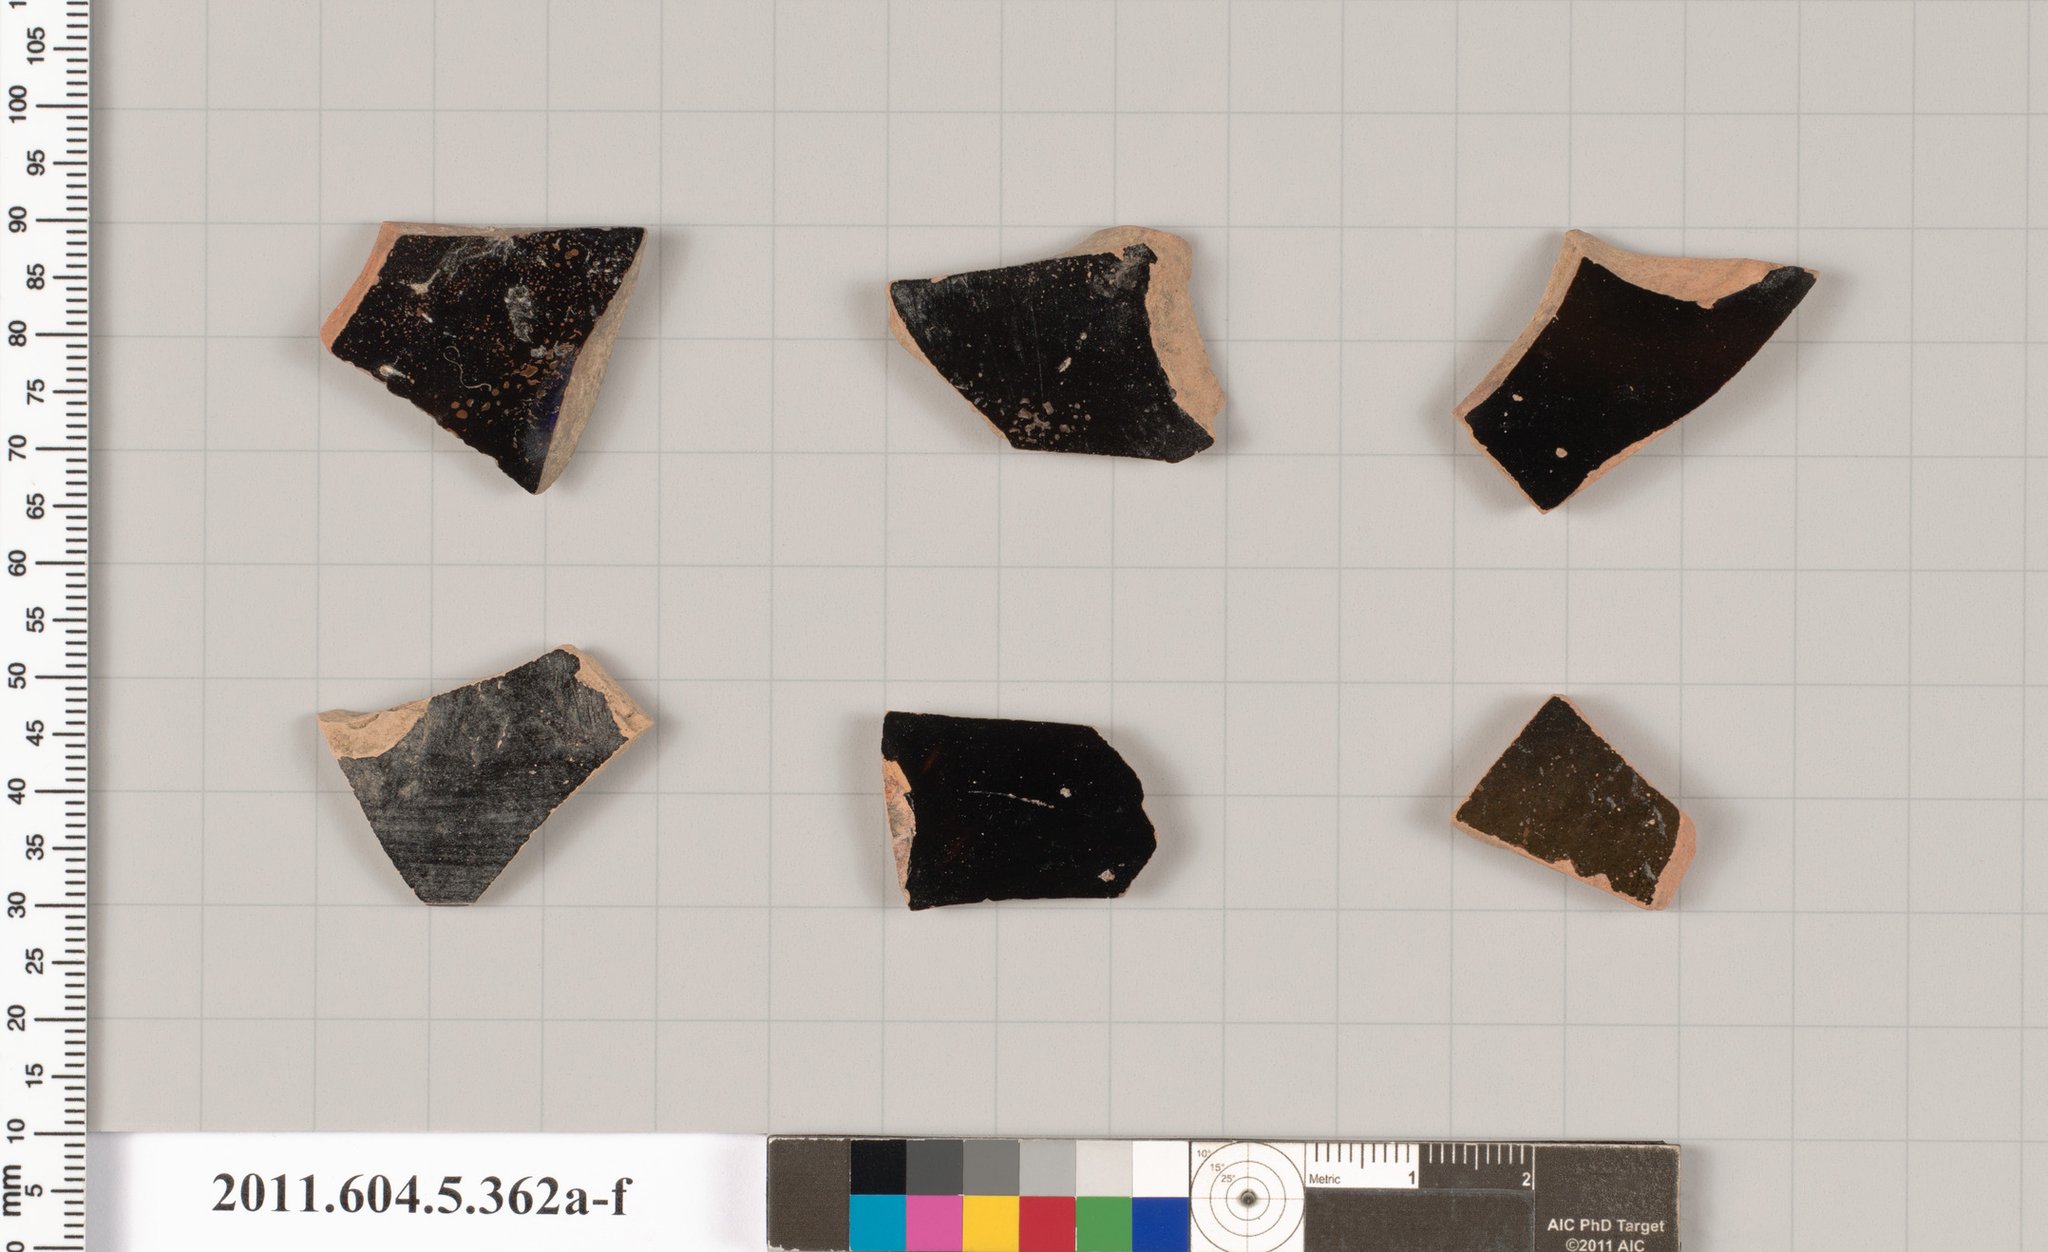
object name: kylix fragment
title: Terracotta fragments of kylikes (drinking cups)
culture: greek, attic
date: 600-401 BCE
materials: terracotta